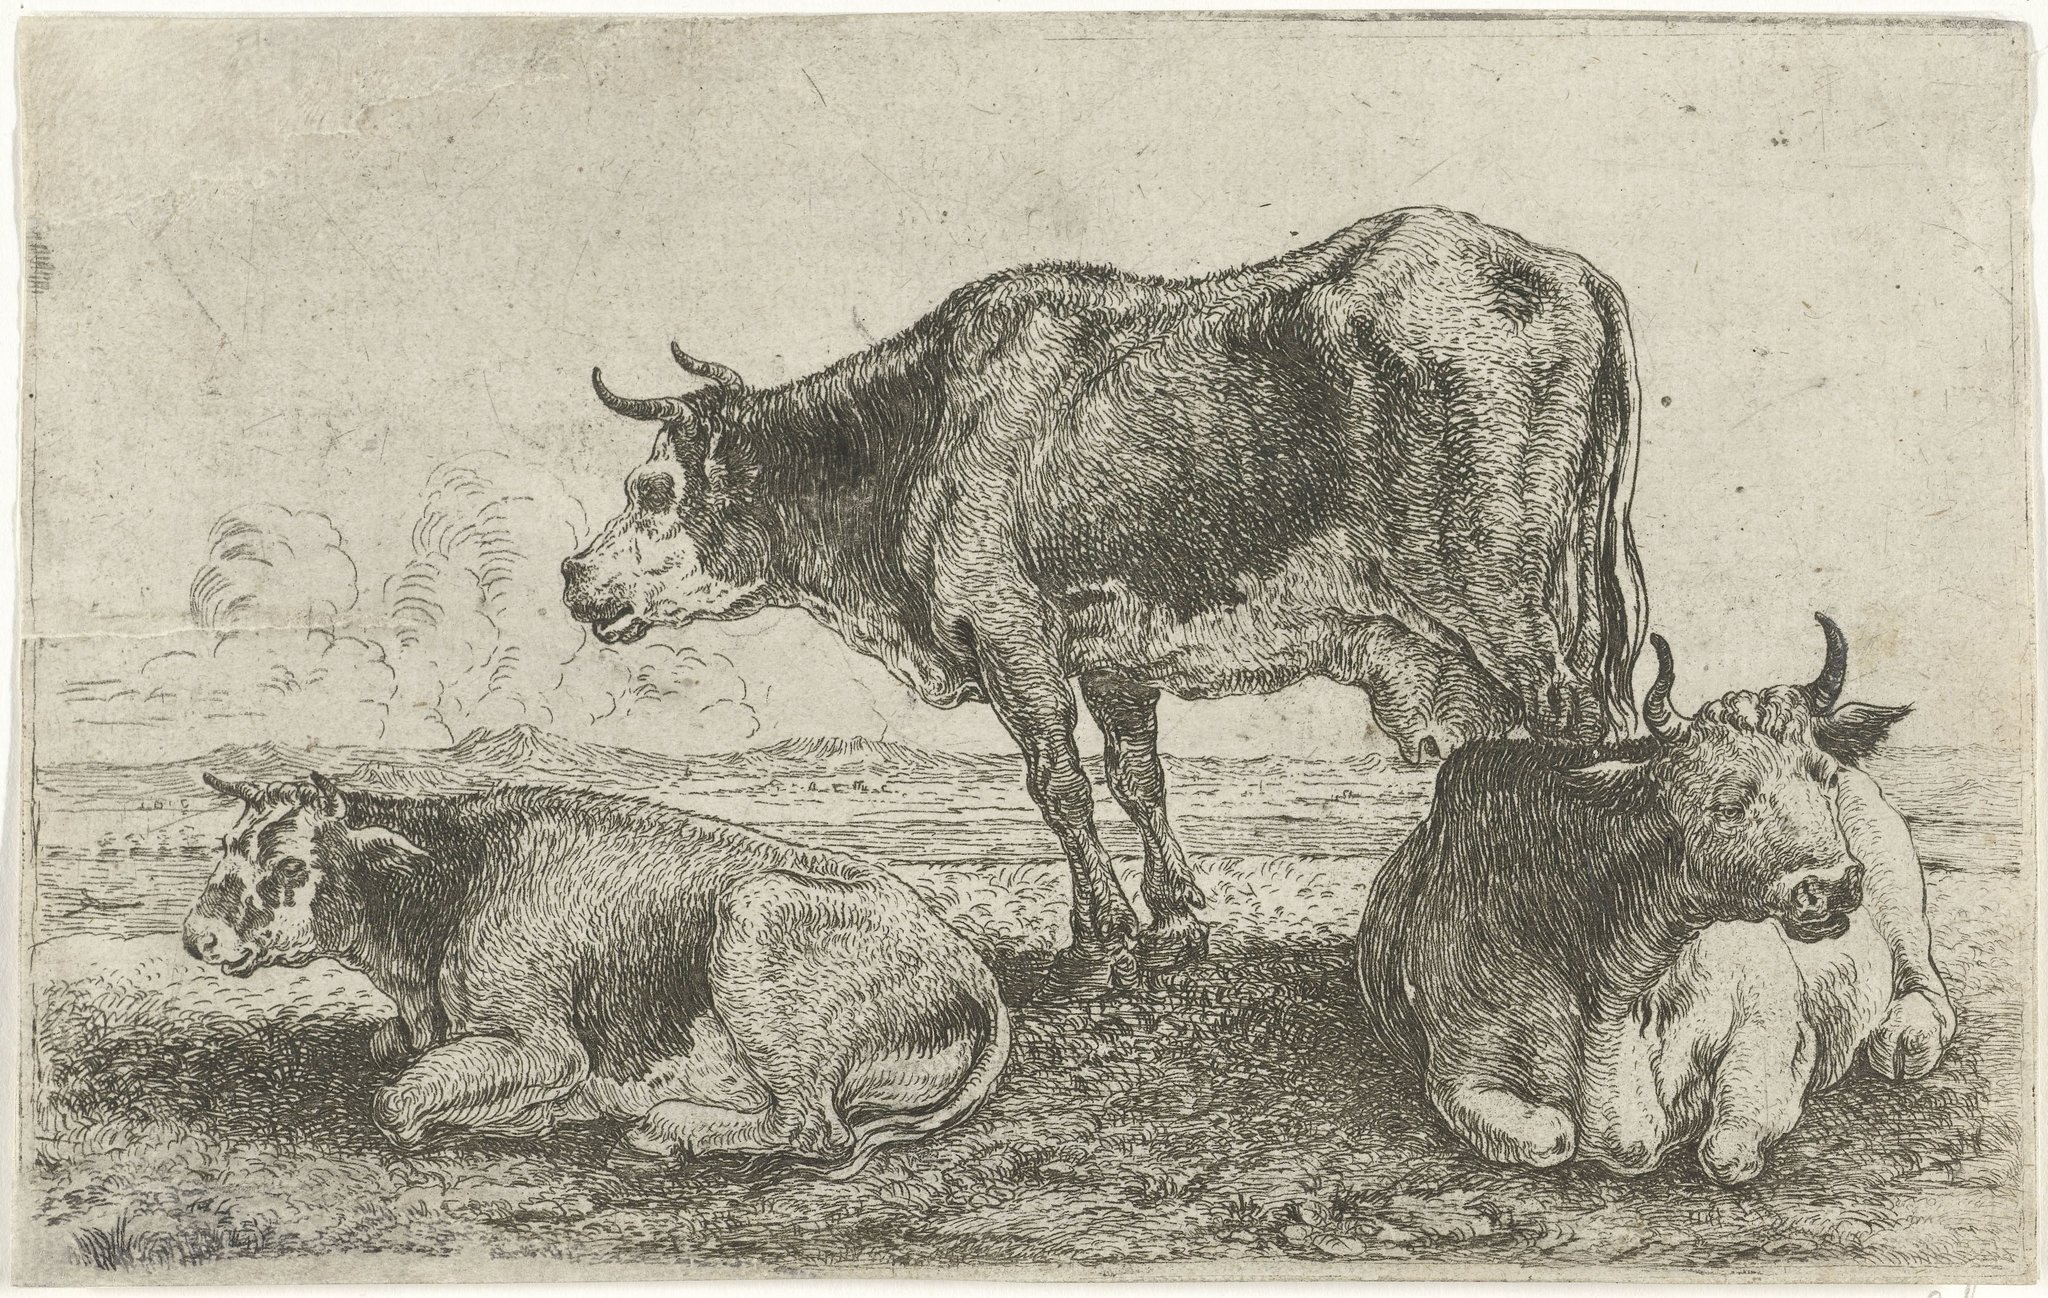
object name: print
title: Dieren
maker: jan van den hecke (i)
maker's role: print maker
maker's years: 1619-1684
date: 1656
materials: paper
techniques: etching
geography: brussels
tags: cow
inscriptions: collector's mark: Lugt 2228